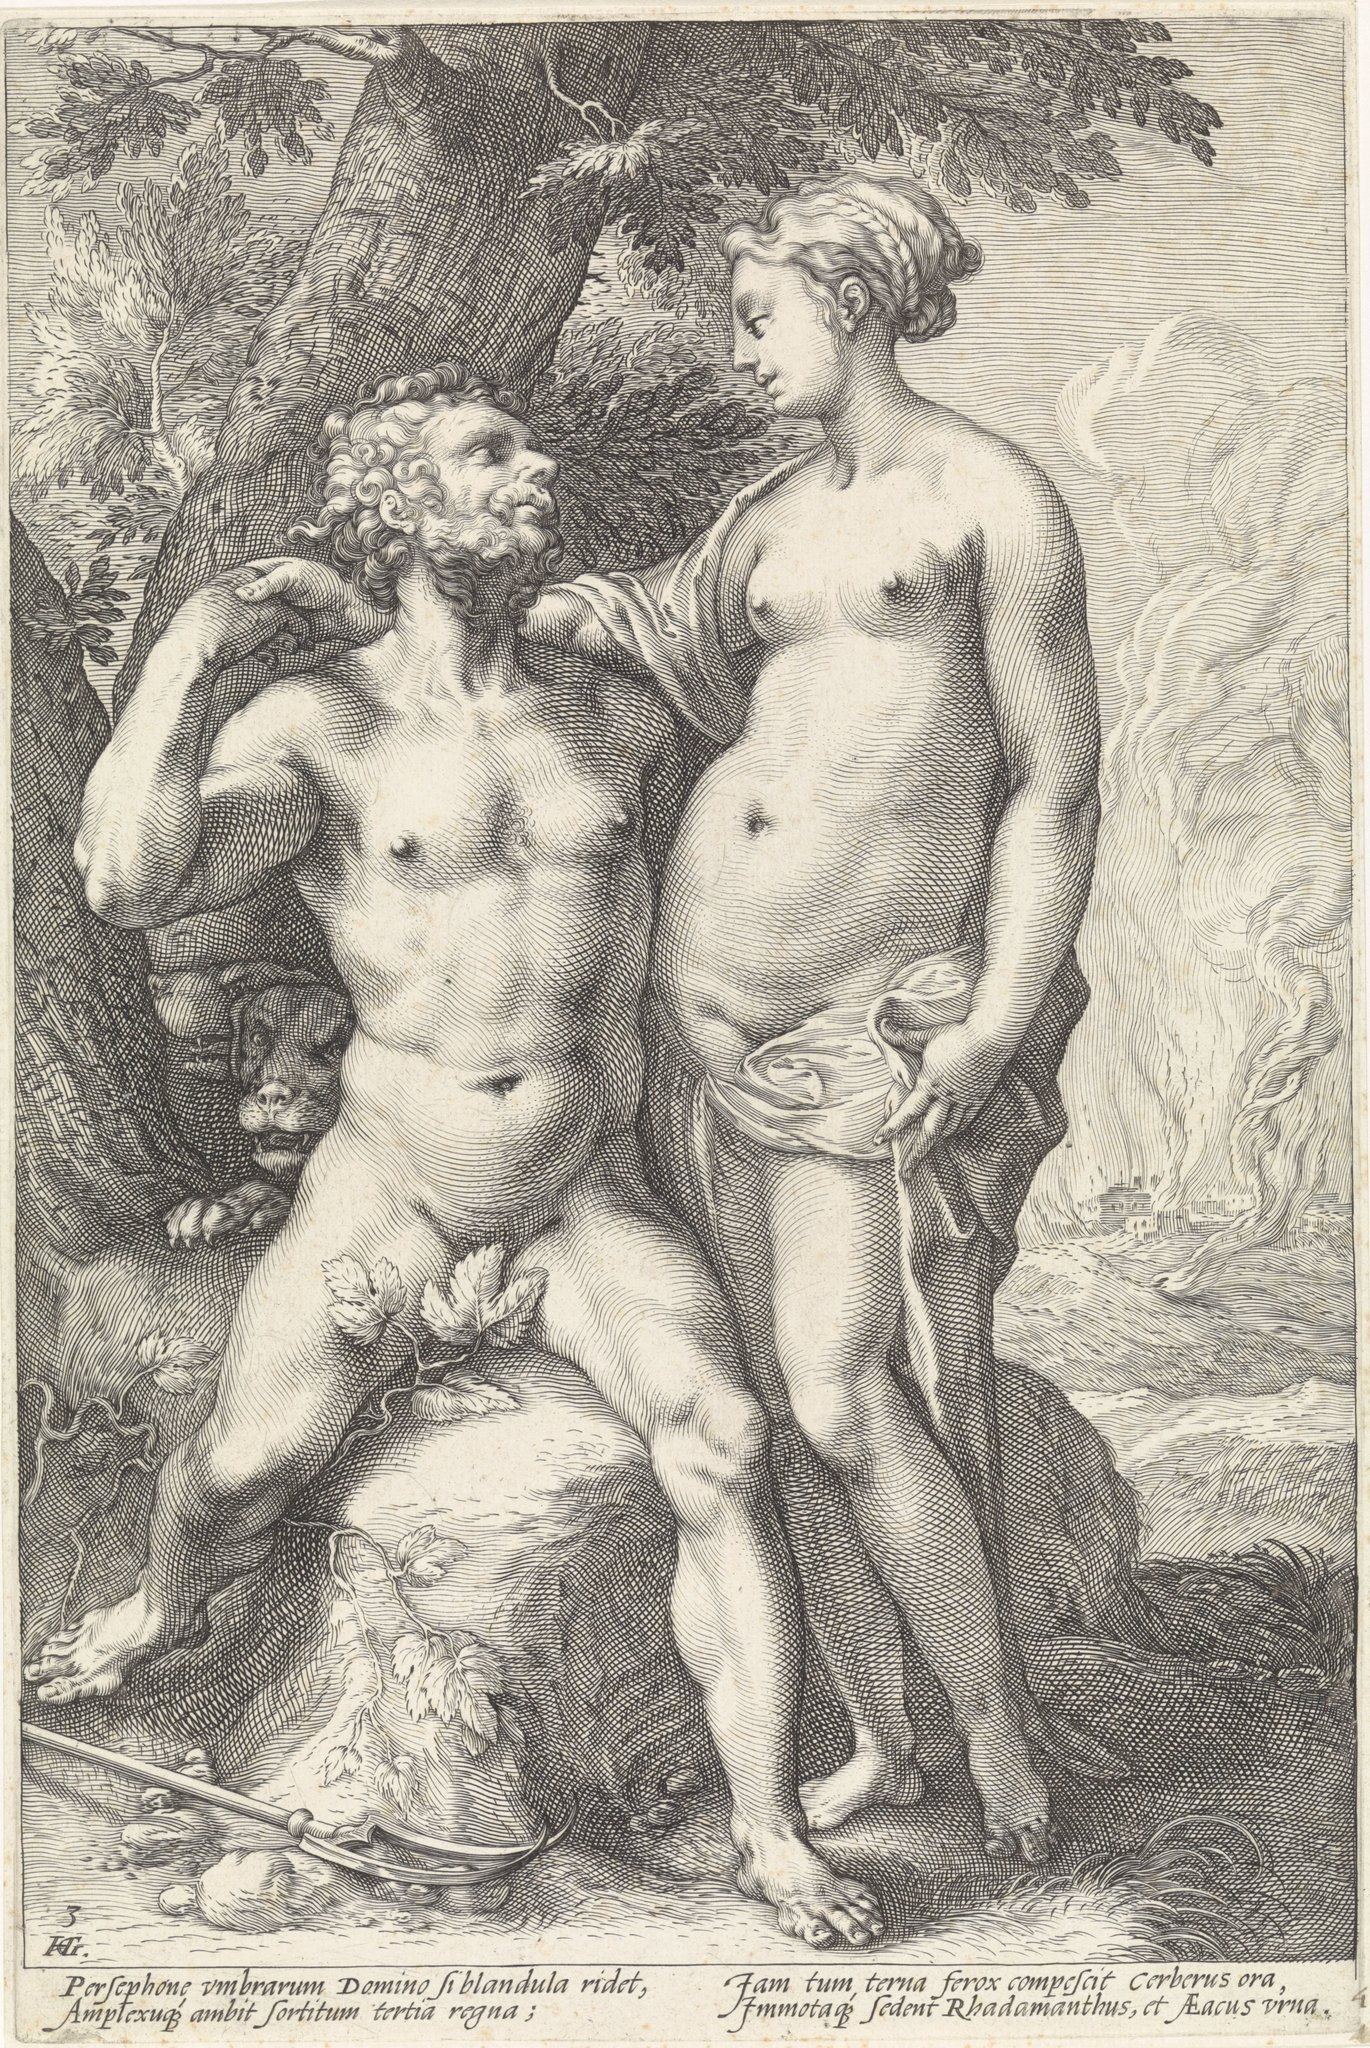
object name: print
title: Godenparen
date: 1575-1607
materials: paper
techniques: engraving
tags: cerberus, the three- or many-headed dog; 'cerbero' (ripa), pluto in love with proserpina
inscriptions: collector's mark: Lugt 11, number: ‘4’, collector's mark: Lugt 10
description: De naakte Pluto en Proserpina in de onderwereld. Ze omhelzen elkaar. Achter Pluto de hellehond Cerberus. De prent is deel van een serie van godenparen en heeft een Latijns onderschrift.